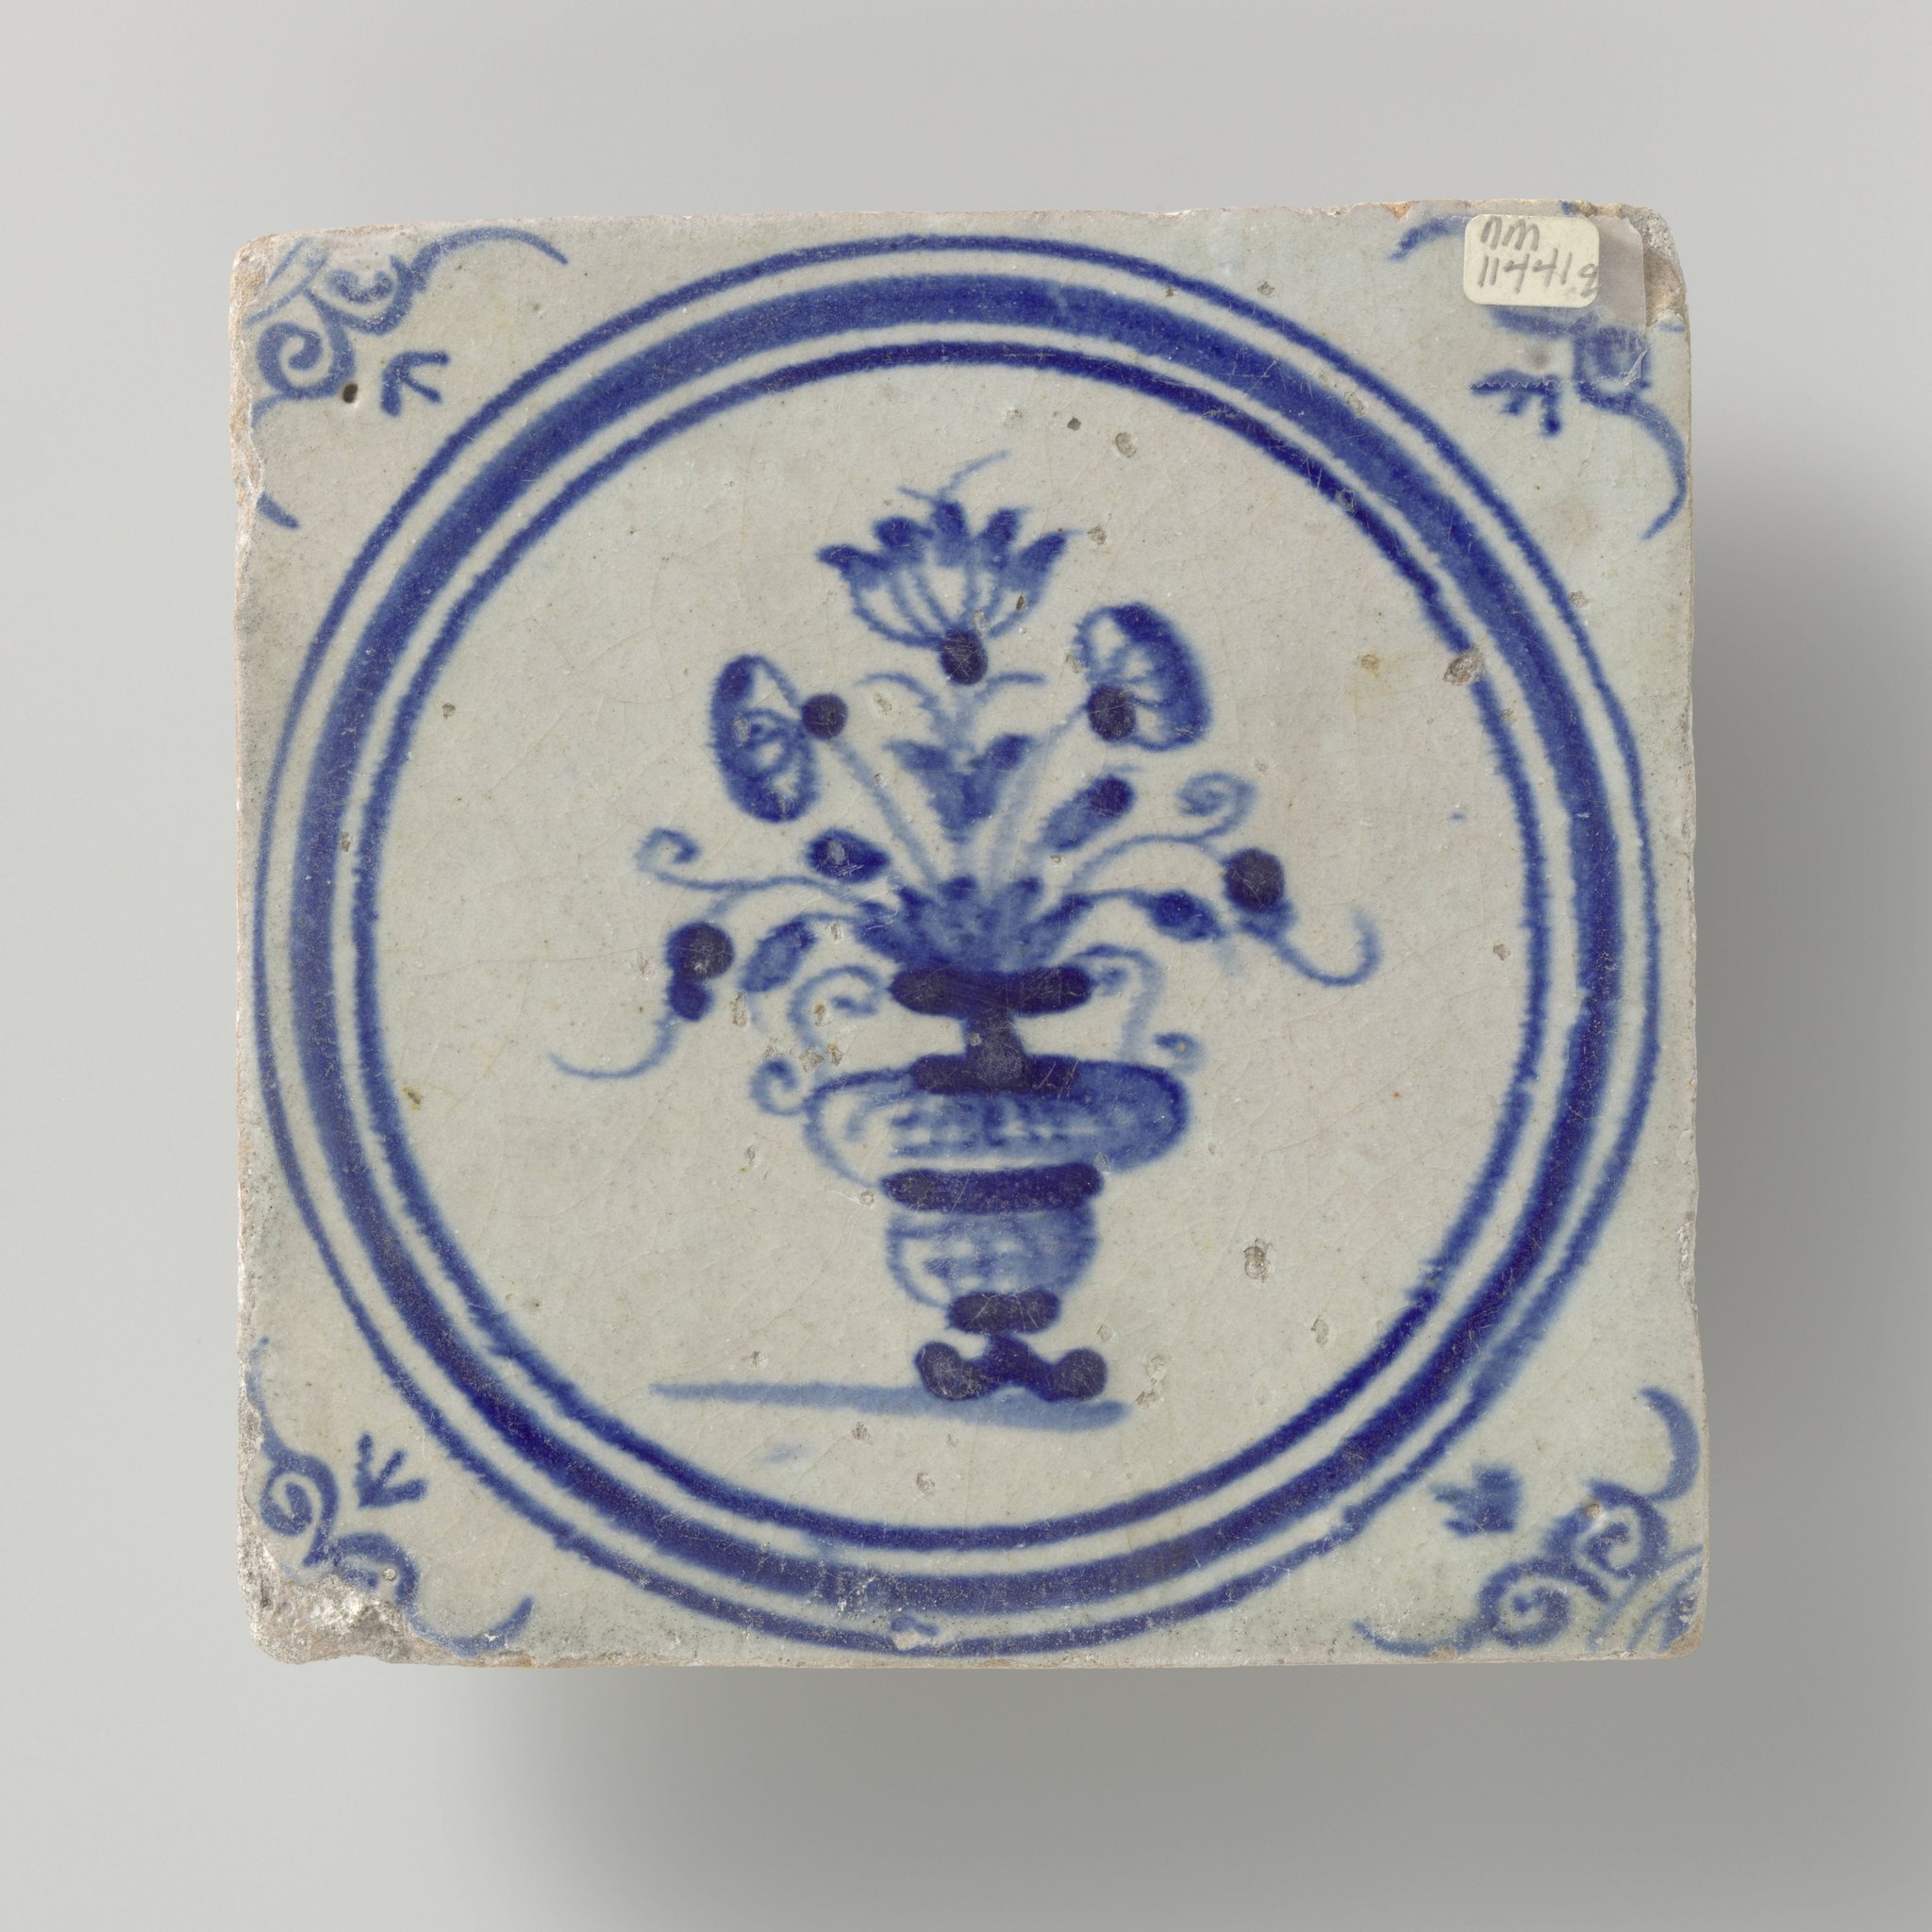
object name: tile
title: Tegel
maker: Anonymous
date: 1640-1660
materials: earthenware, glaze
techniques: maiolica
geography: netherlands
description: Tegel met een blauw geschilderde bloemvaas binnen een cirkel. In de hoeken, een ossekop.